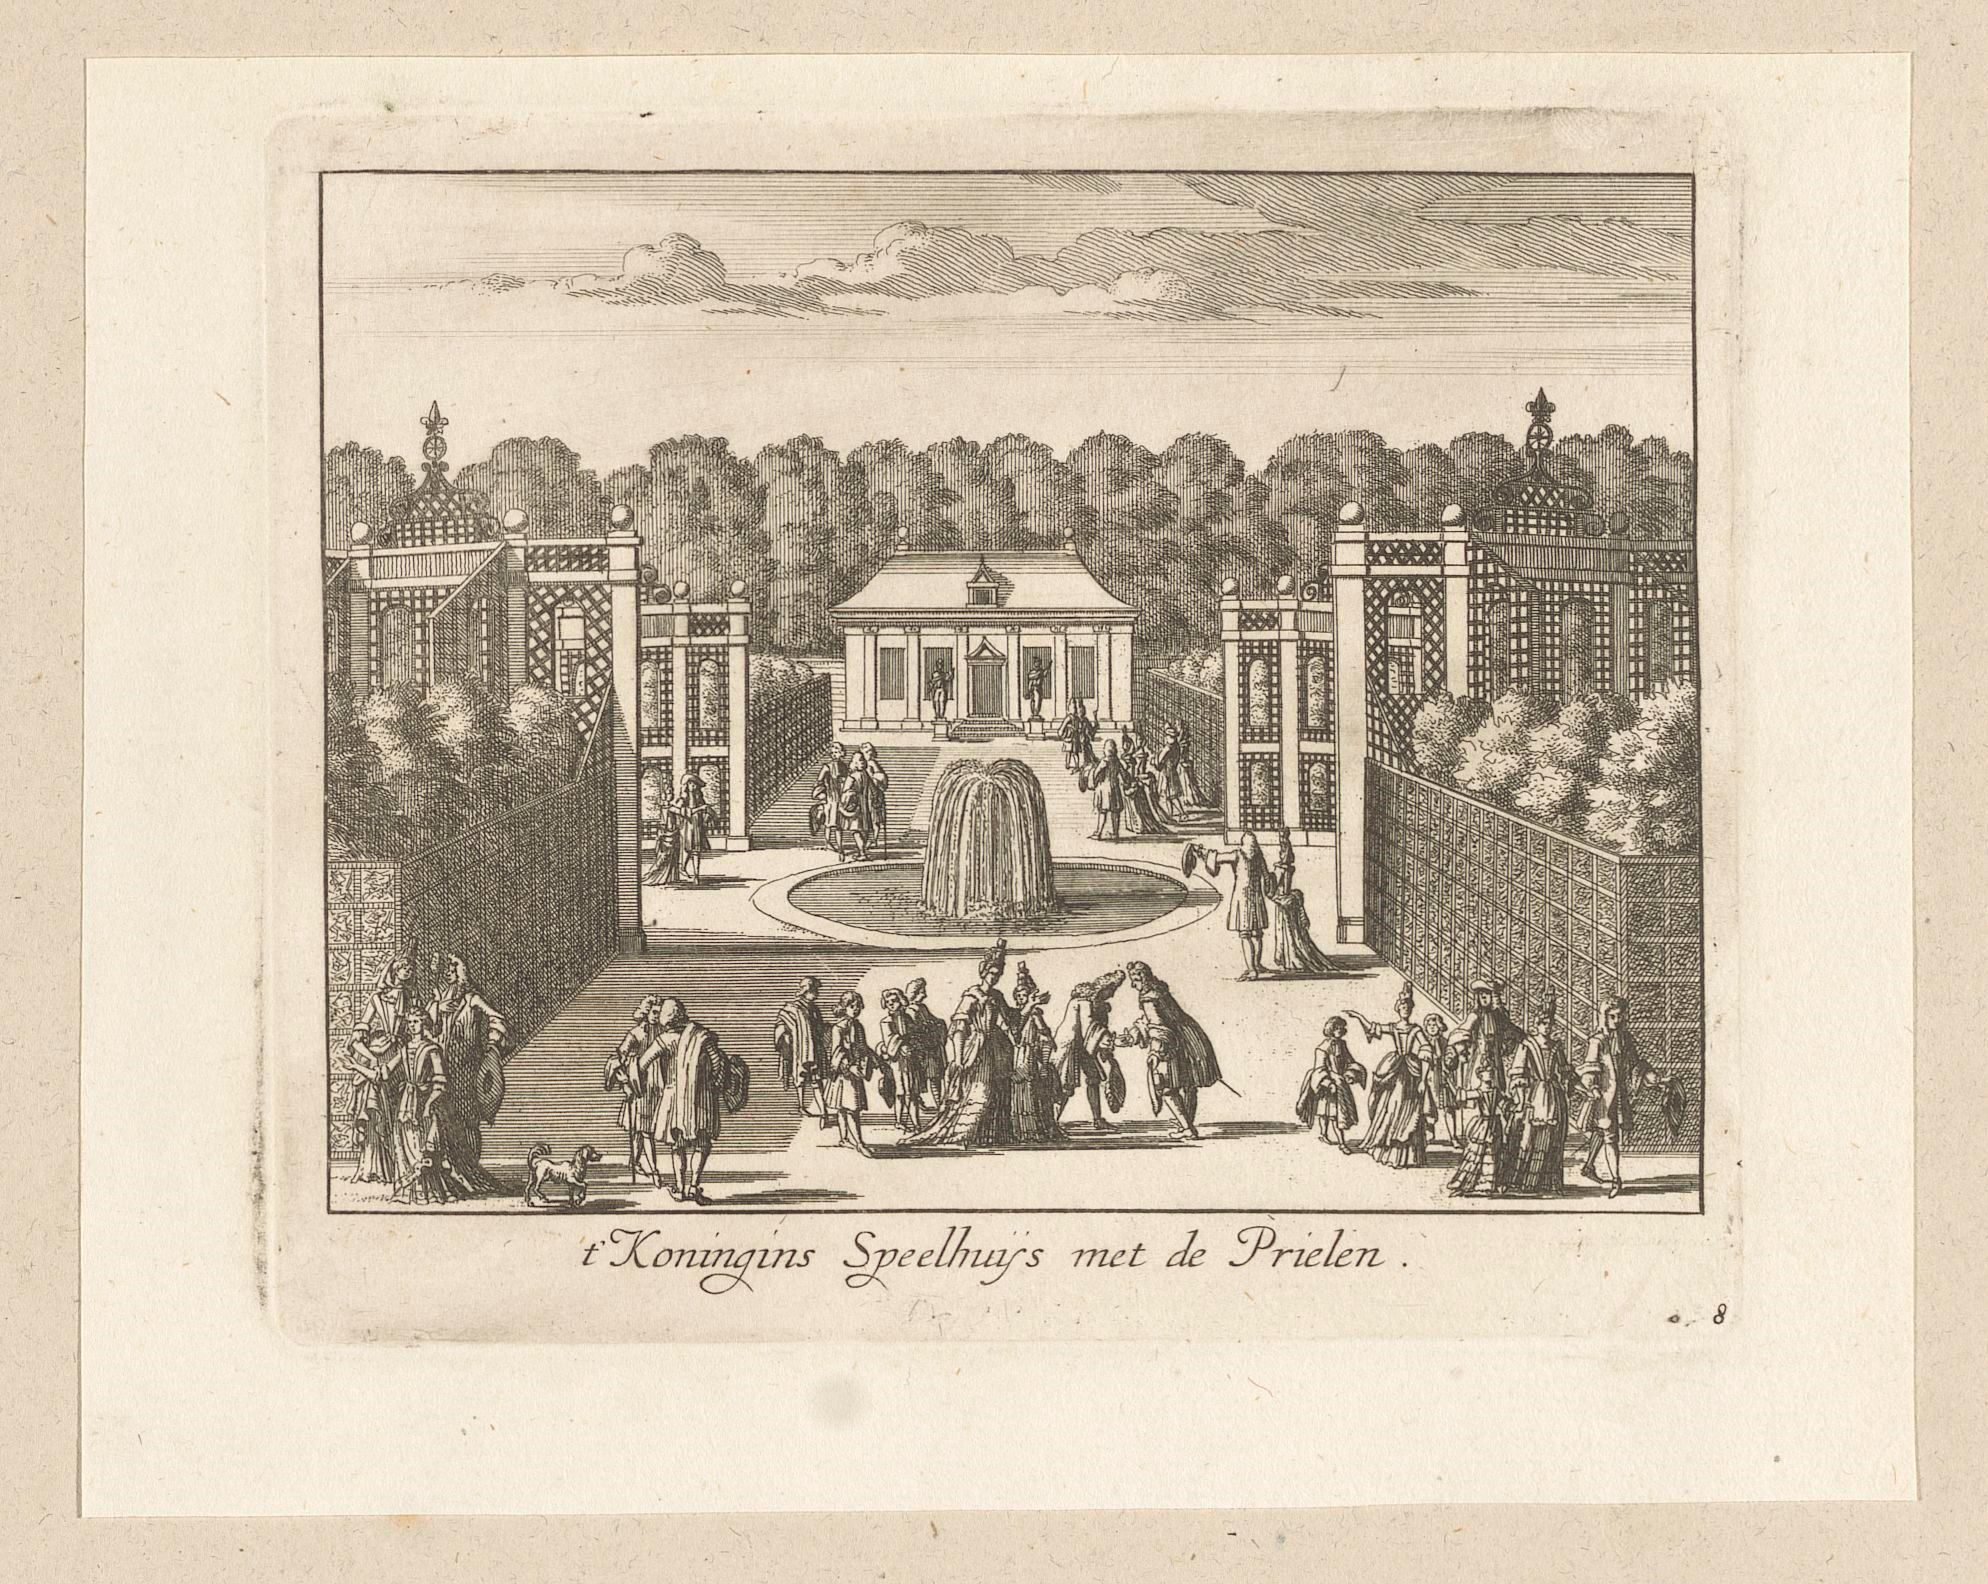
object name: print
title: Zestien prenten van Paleis Honselaarsdijk (Danckerts / Covens en Mortier)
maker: cornelis danckerts (ii)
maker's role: print maker, publisher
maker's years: 1664-1717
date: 1696-1717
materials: paper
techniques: etching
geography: amsterdam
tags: palace, french or architectonic garden; formal garden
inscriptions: collector's mark: Lugt 2233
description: Fontein in het park van Paleis Honselaarsdijk met eromheen groepjes wandelaars. De lanen en het plein met de fontein worden begrensd door schuttingen. Op de achtergrond een prieel. Rechtsonder genummerd: 8. Prent uit een serie van zestien prenten van Paleis Honselaarsdijk.